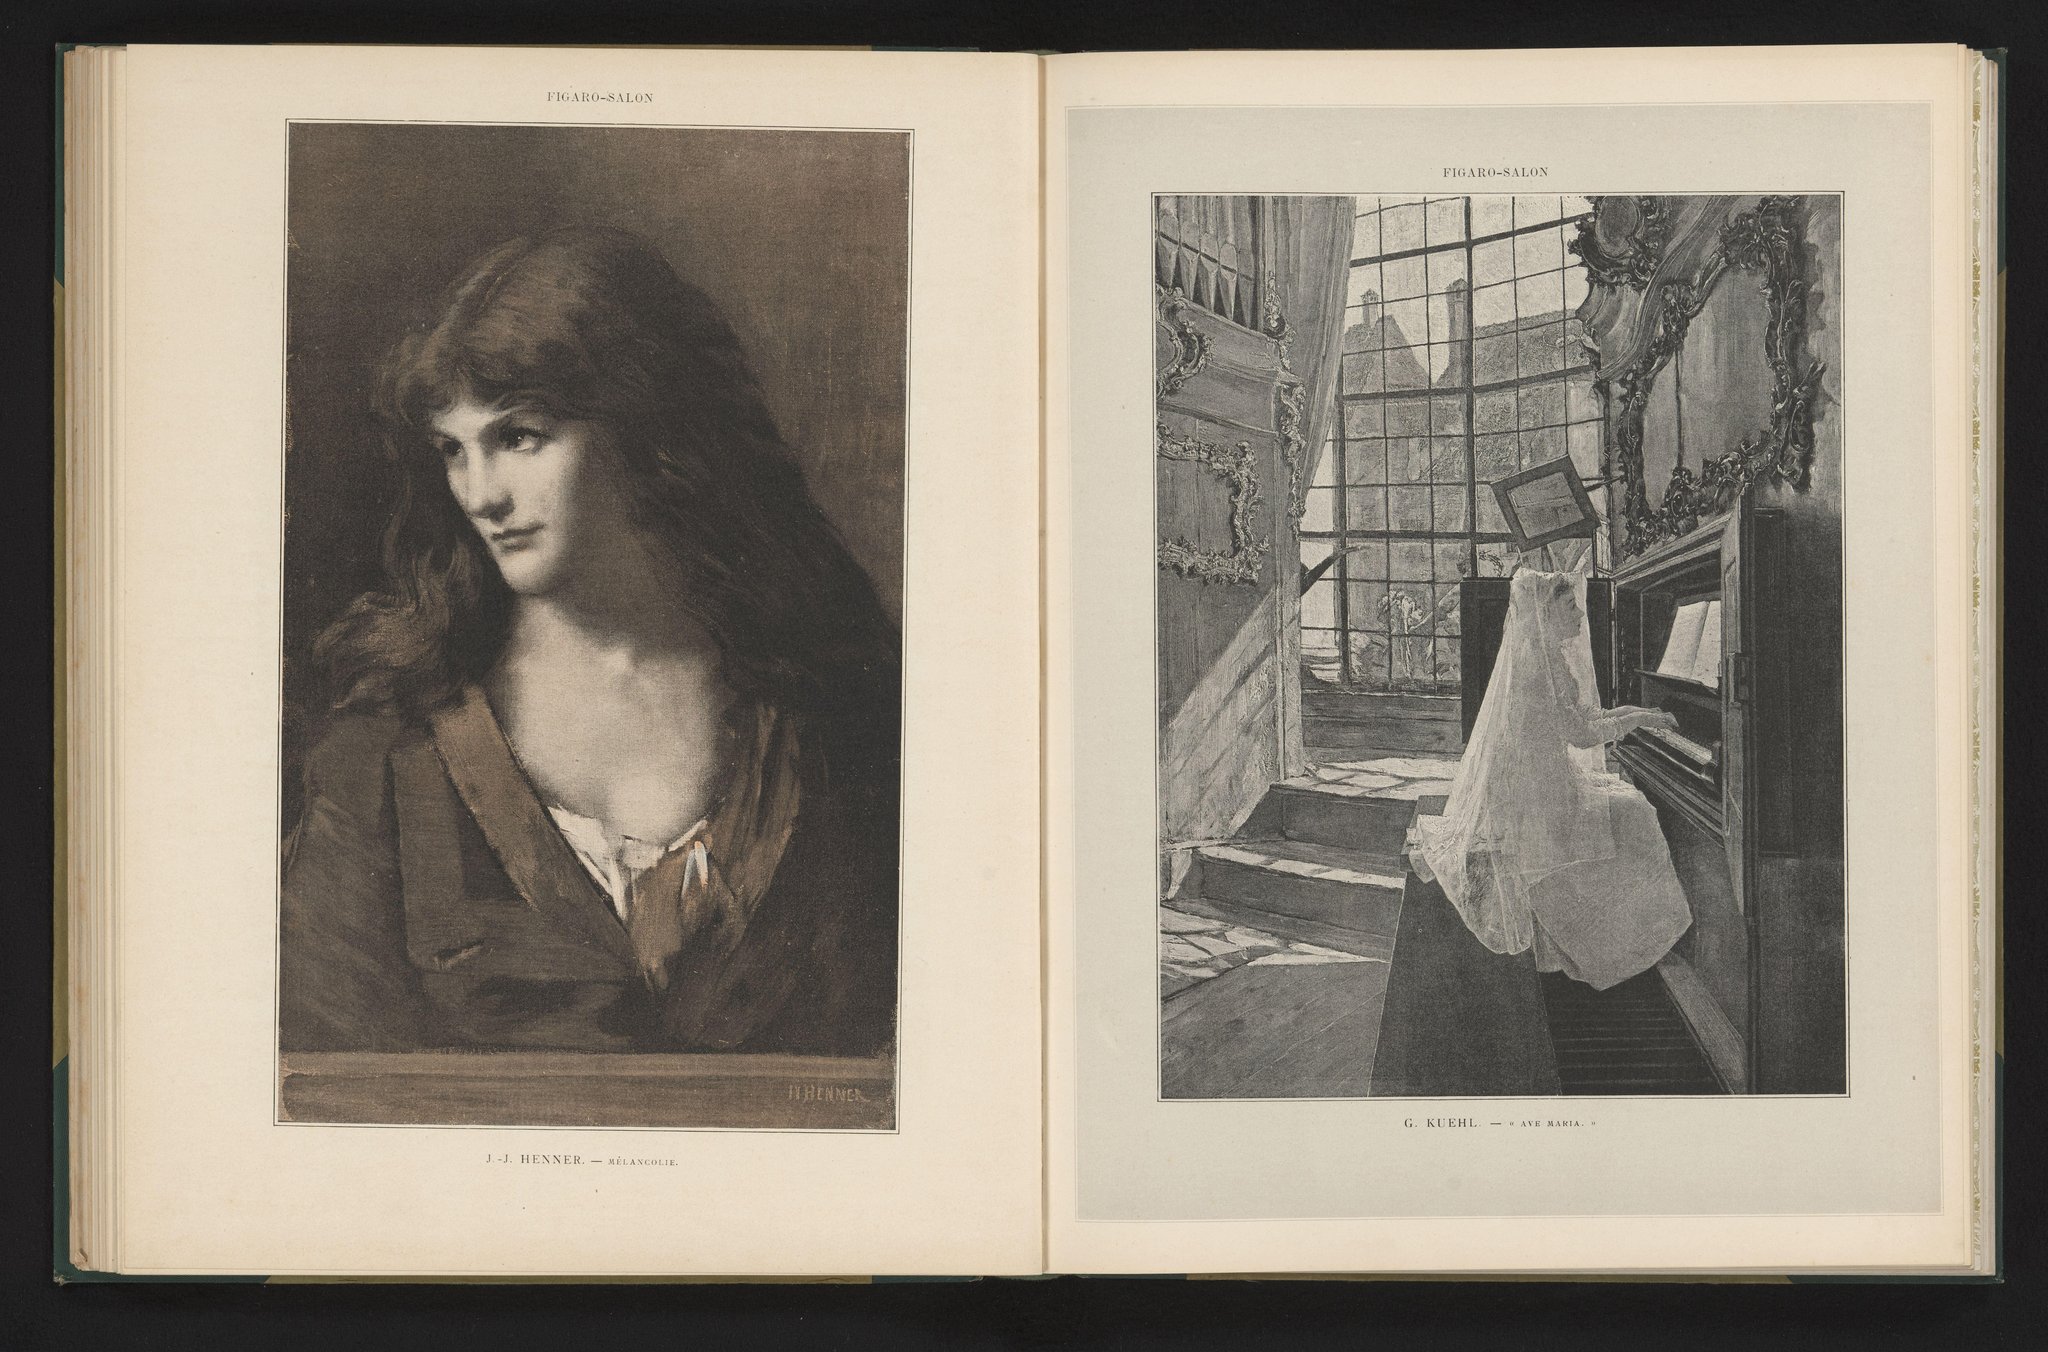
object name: page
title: Reproductie van een schilderij van een interieur met een pianospelende vrouw door Gotthardt Kuehl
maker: Anonymous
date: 1885-1901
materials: paper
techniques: autotype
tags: adolescent, young woman, maiden, interior of the house, keyboard instruments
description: Prent op pagina 101 van Figaro-Salon (par Albert Wolff).